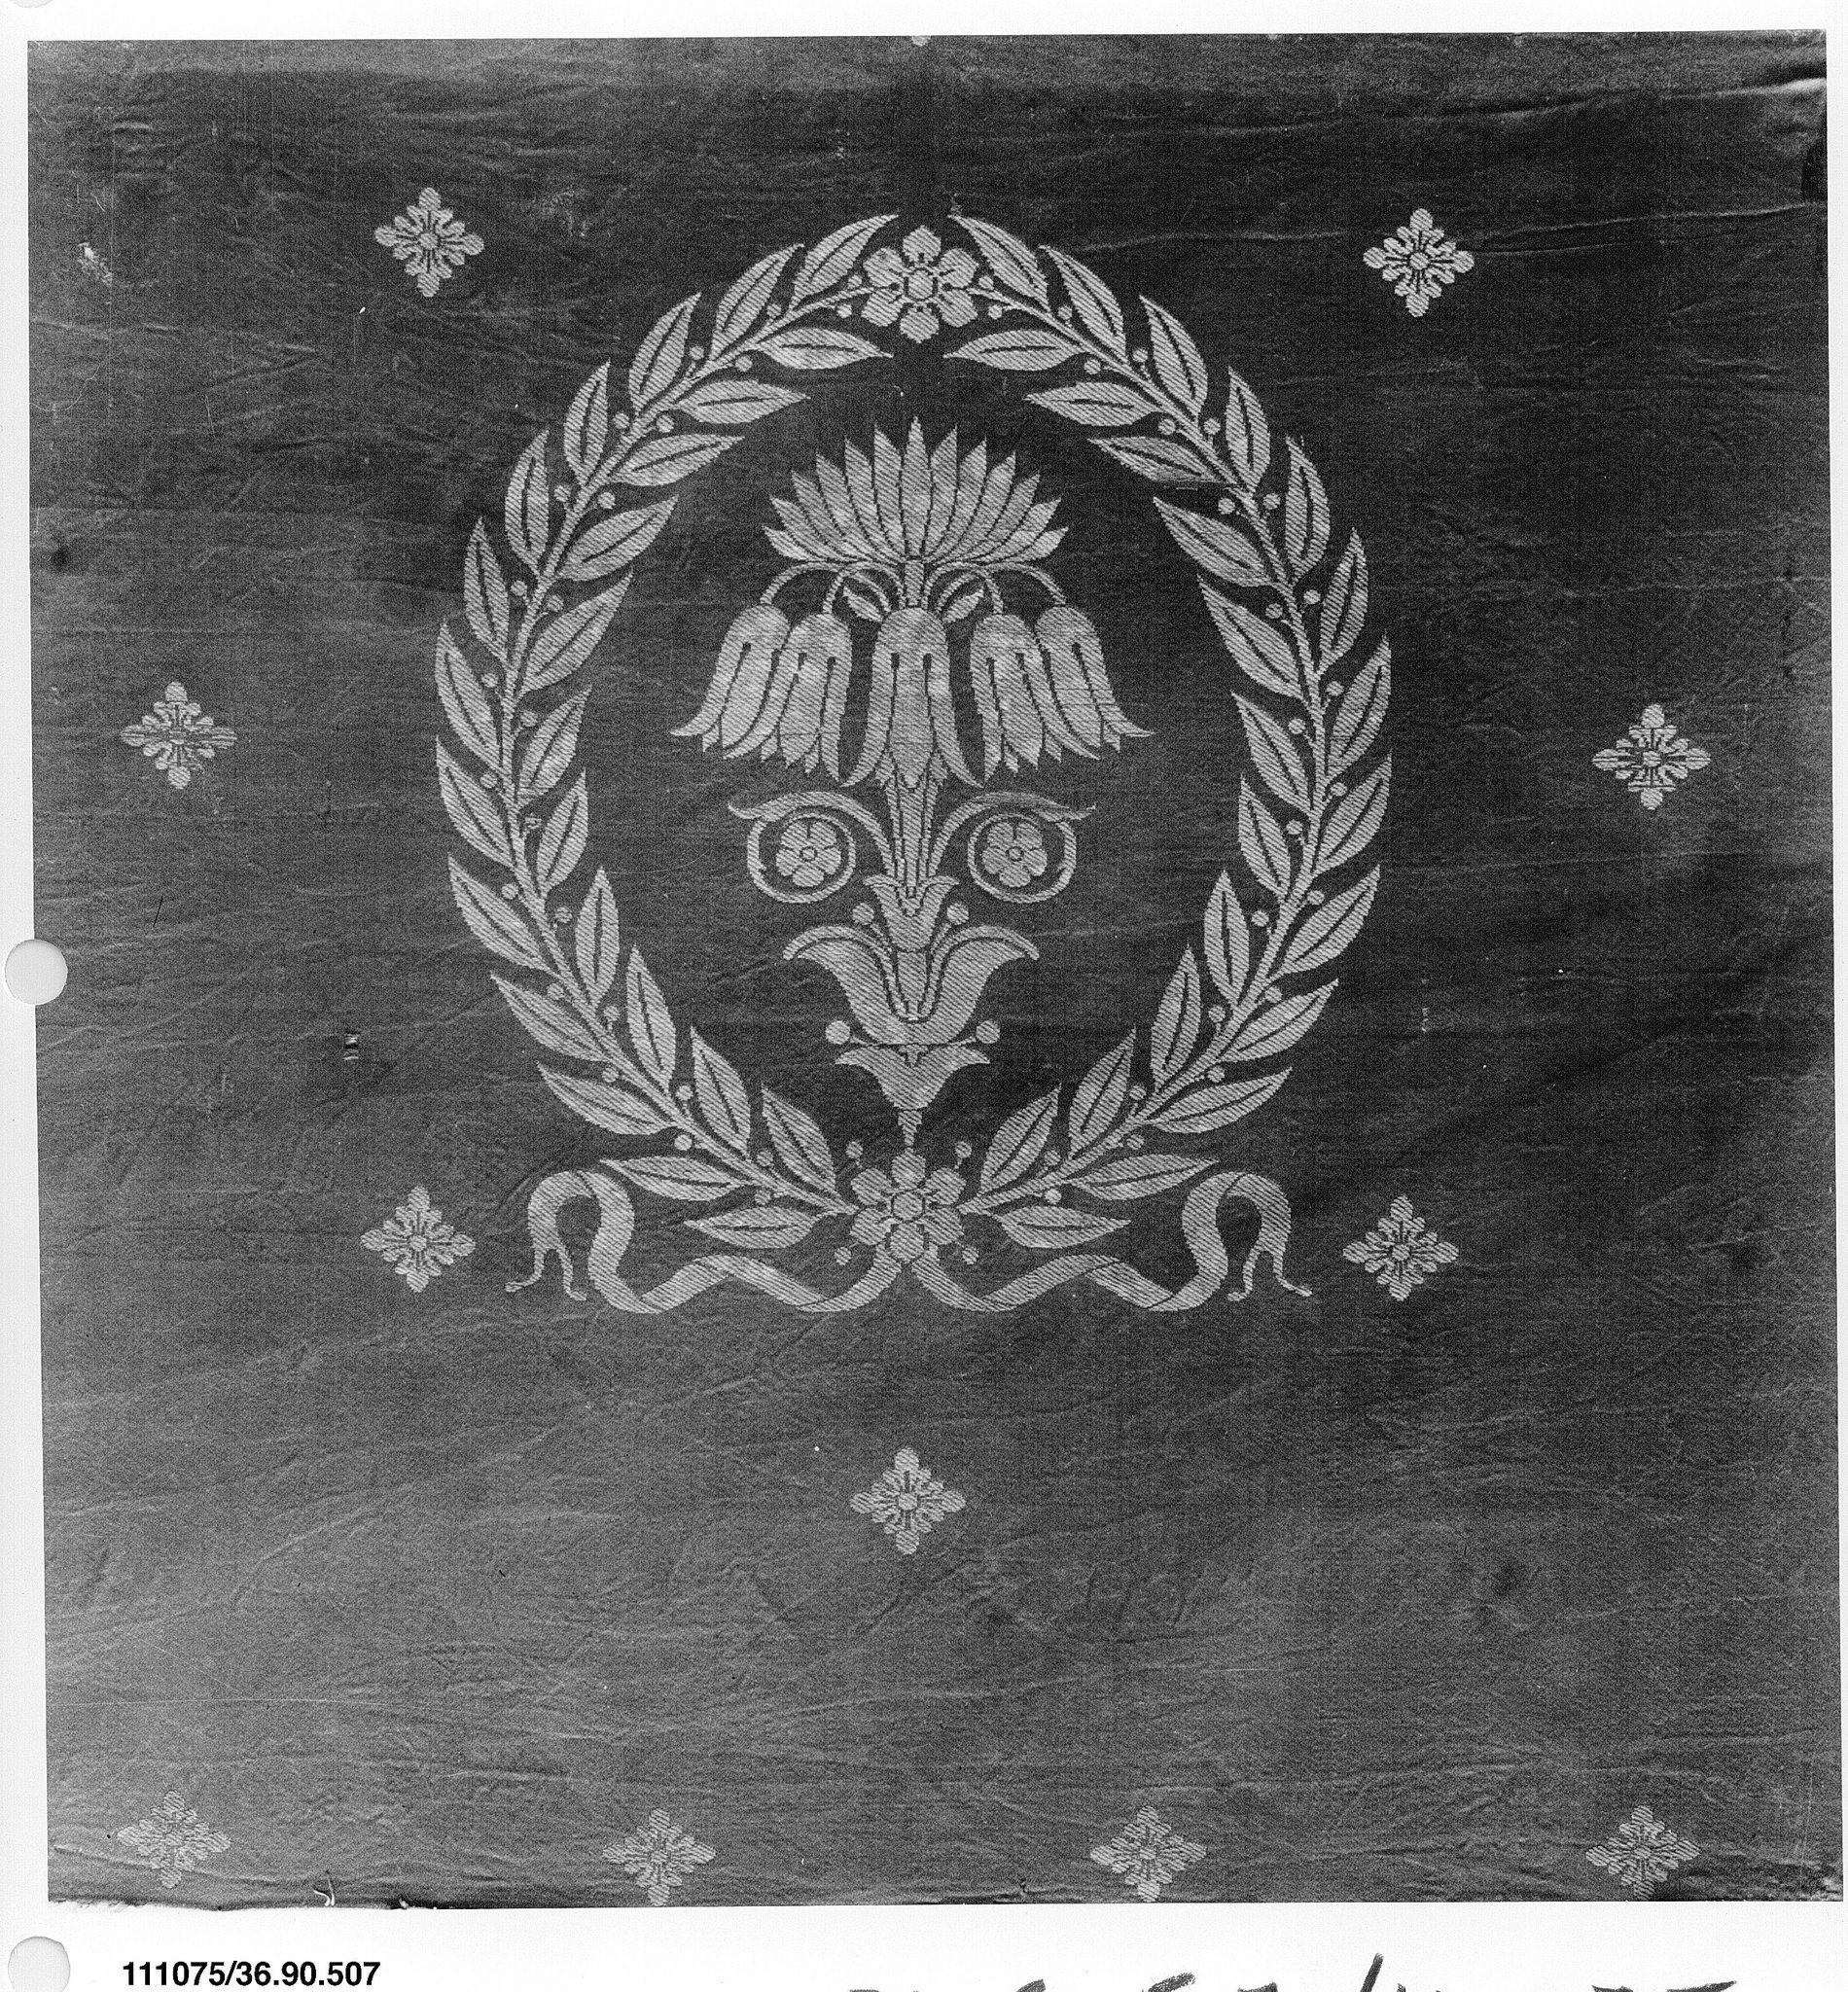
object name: piece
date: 1805-1815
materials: silk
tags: flowers